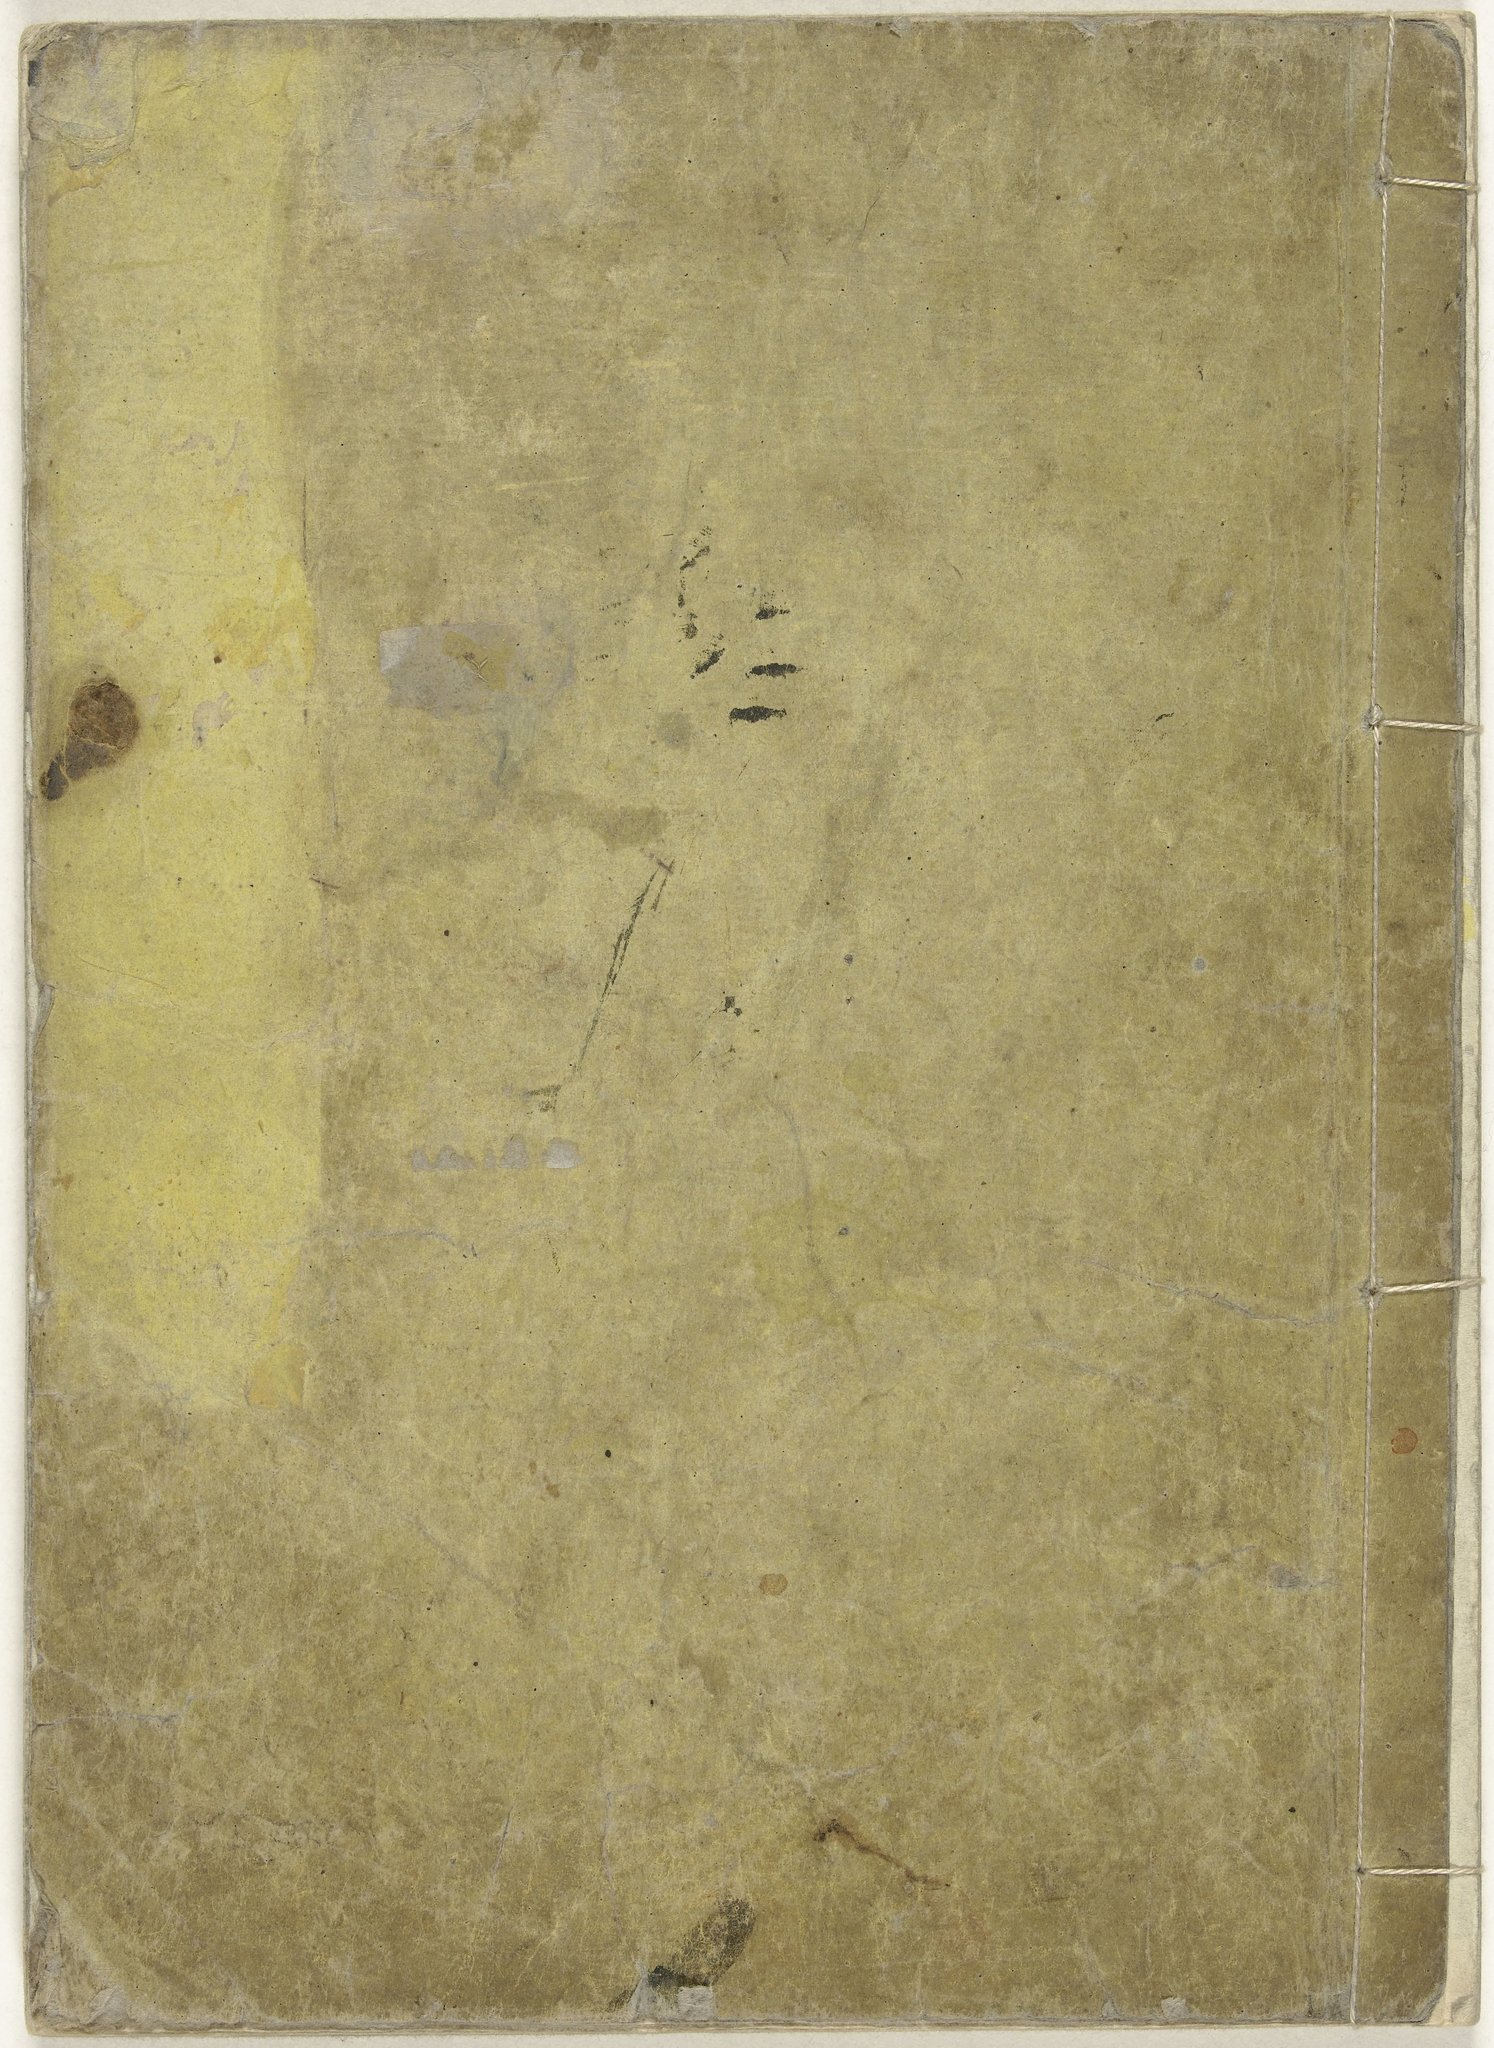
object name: book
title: Beroemde gezichten op Japan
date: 1839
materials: paper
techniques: woodcut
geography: japan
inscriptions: collector's mark: Lugt 2228